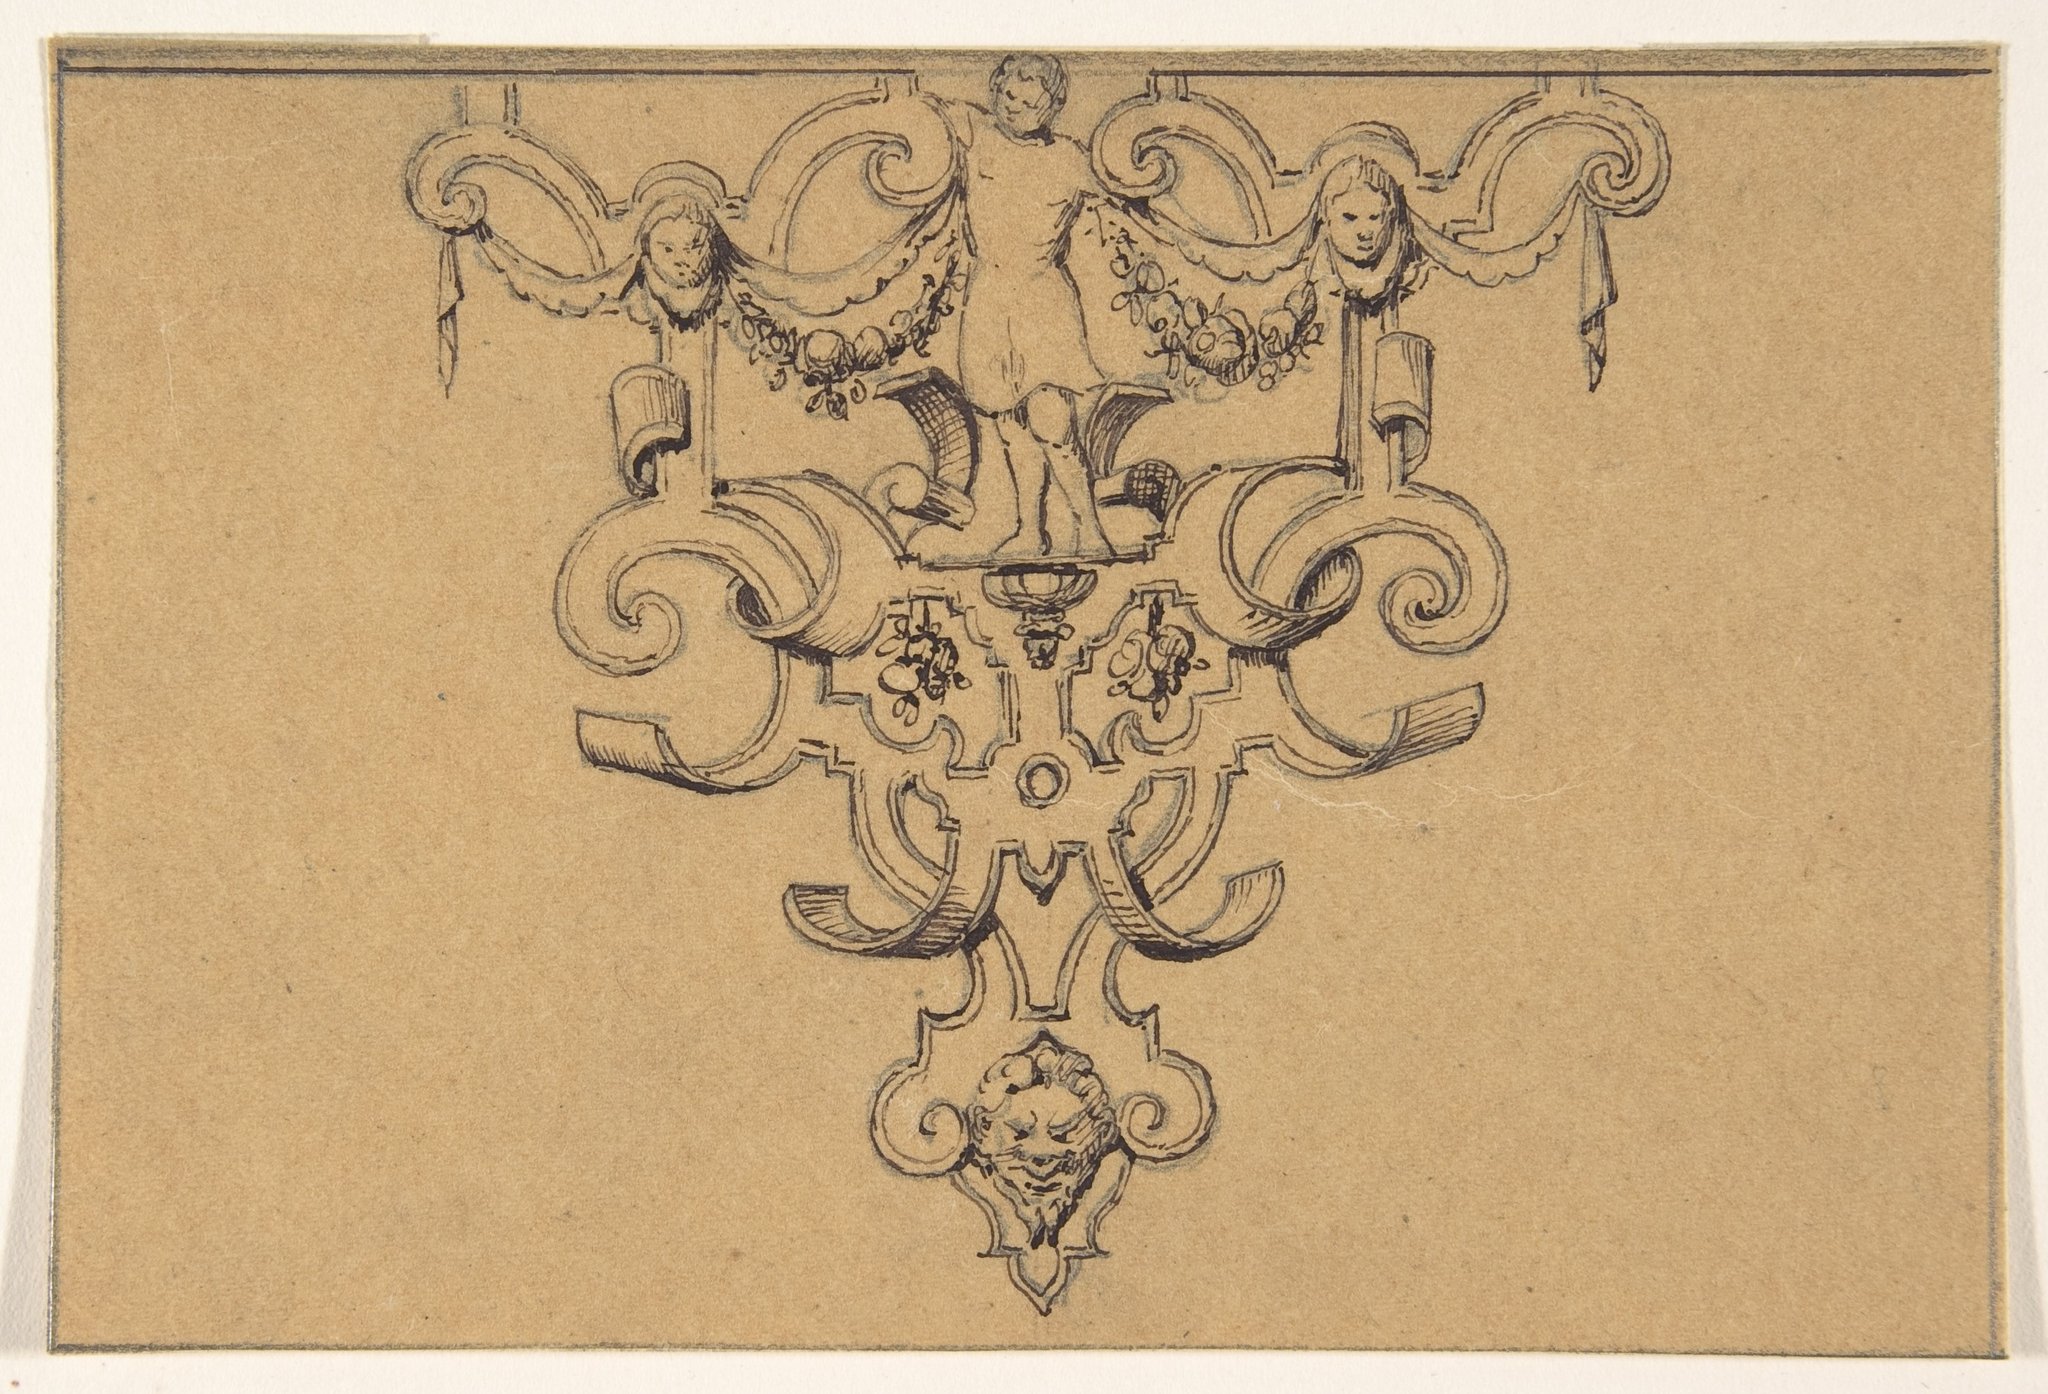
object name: drawing ornament architecture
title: Design for Strapwork Ornament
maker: anonymous, french, 19th century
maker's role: artist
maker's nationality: french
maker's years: 1800-1900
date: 1801-1900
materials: graphite, ink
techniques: pen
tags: ornament